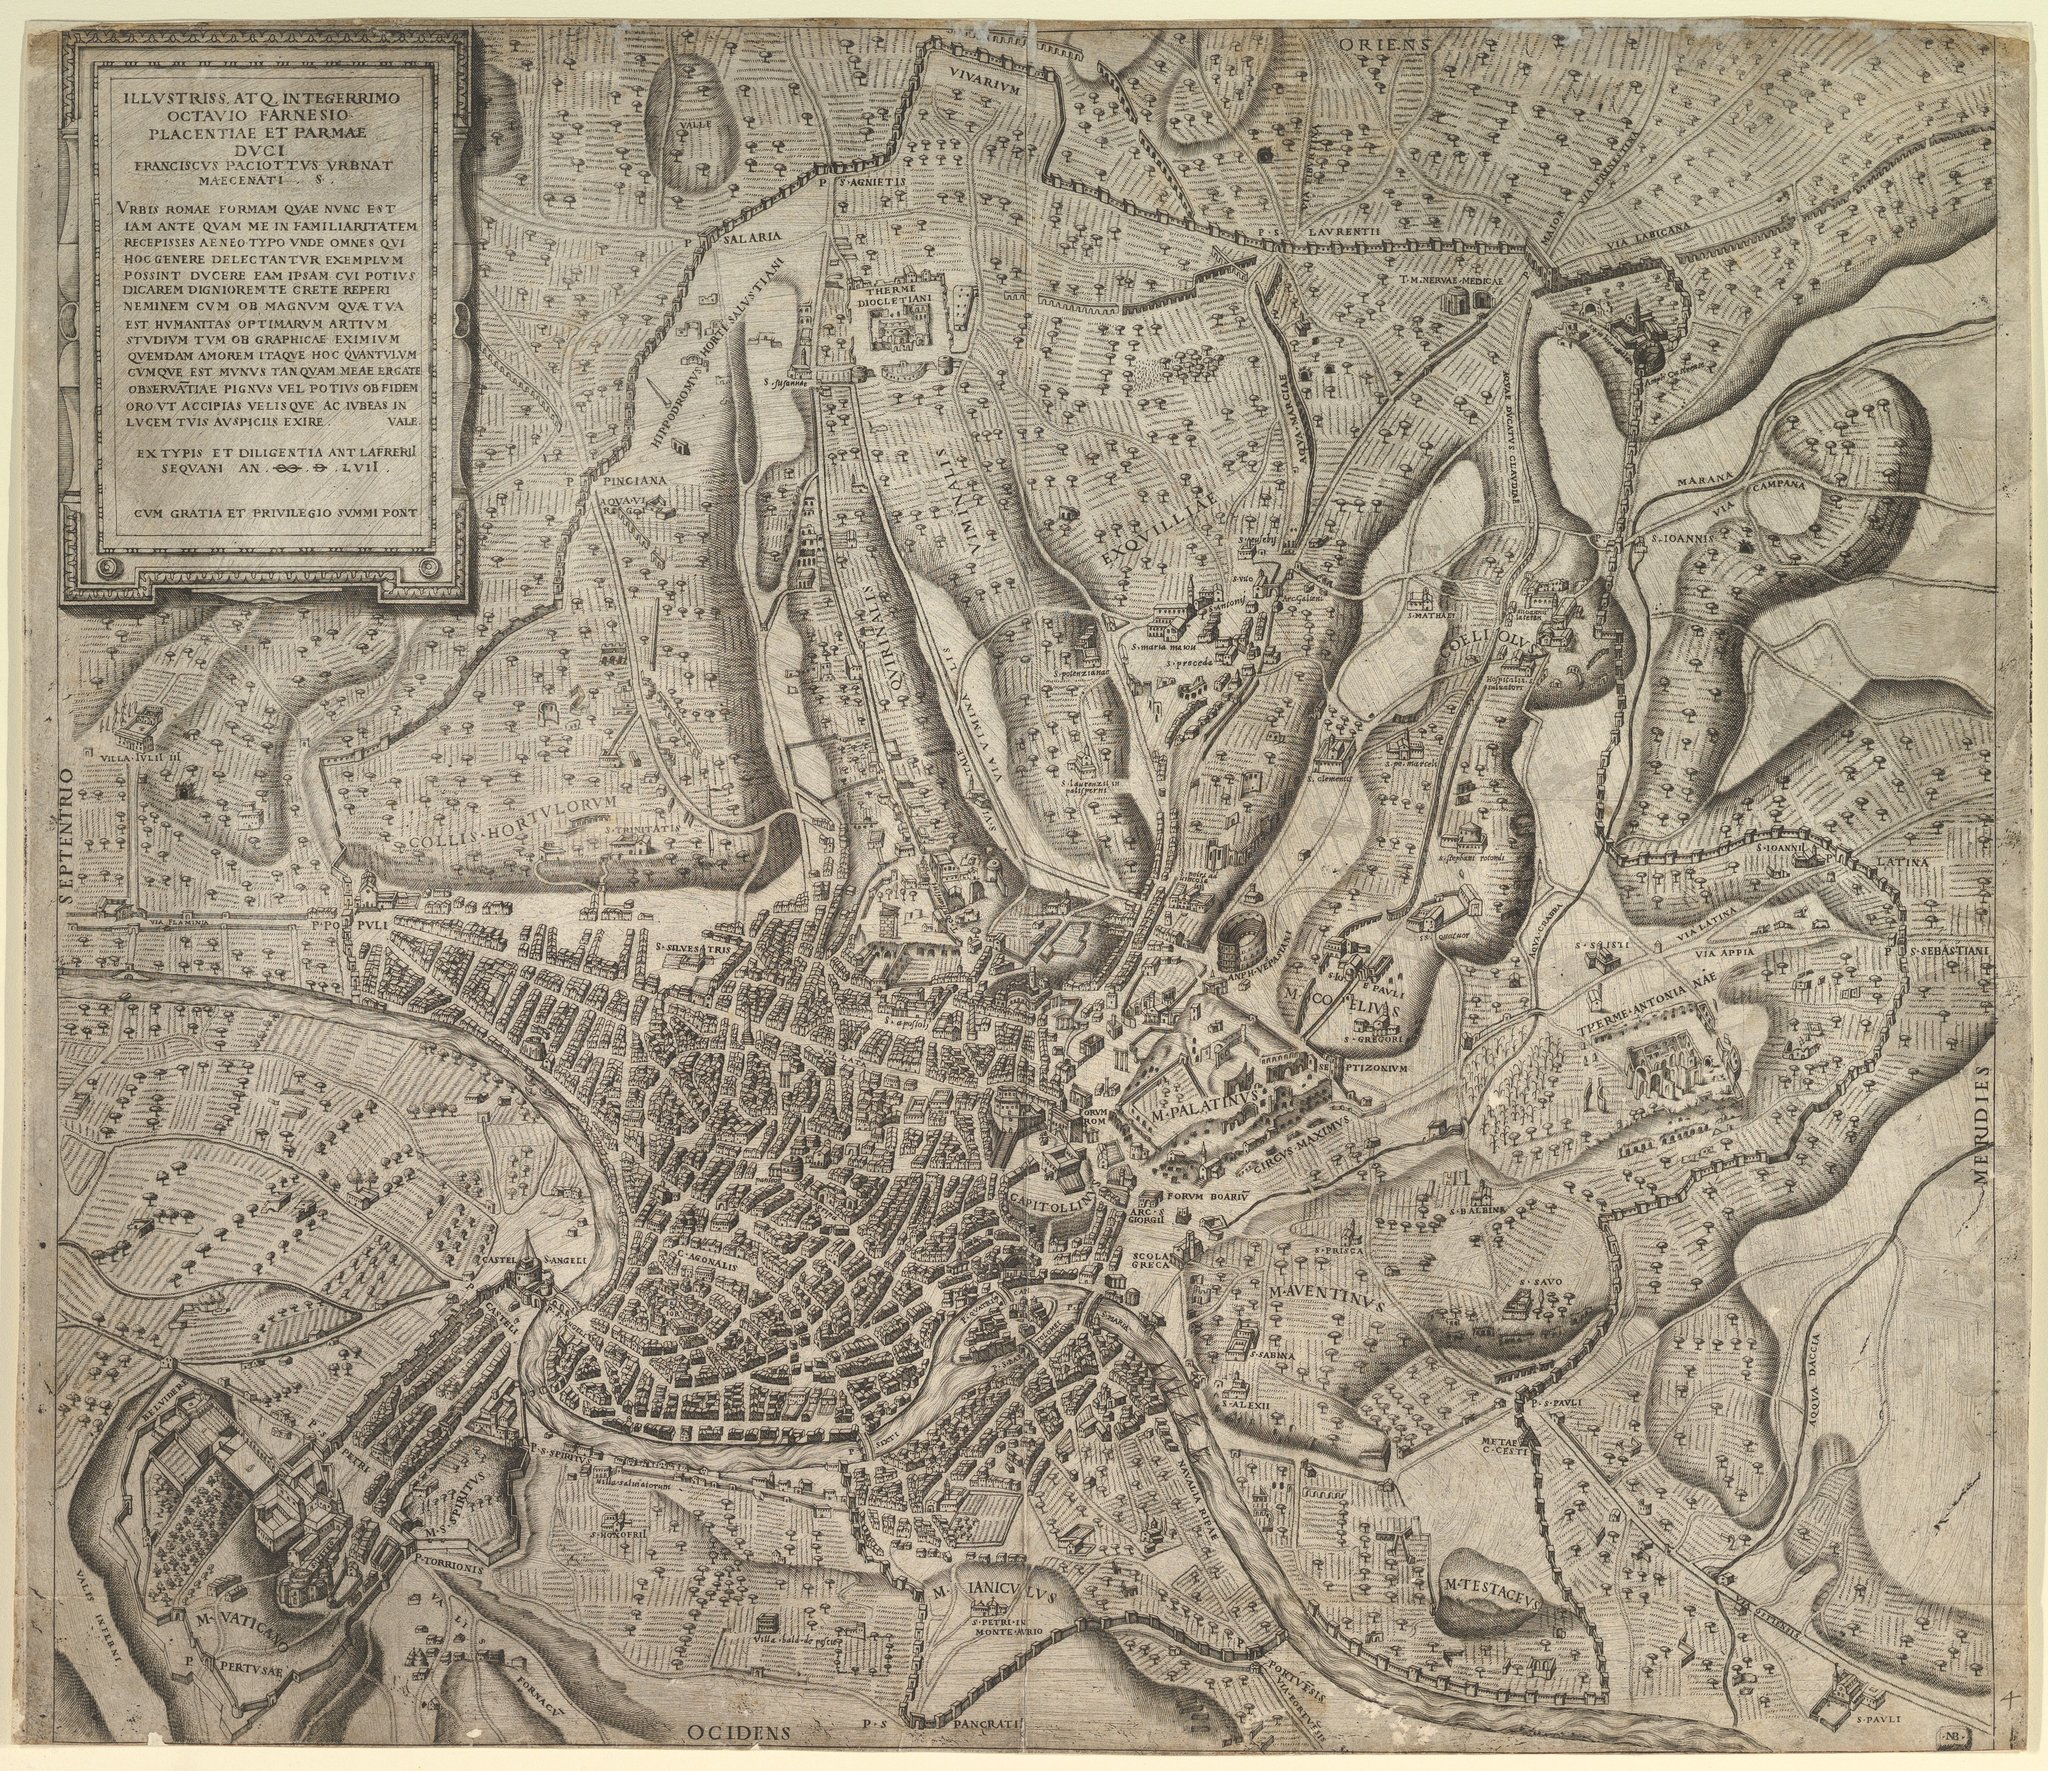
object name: print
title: View of Rome from the West, from "Speculum Romanae Magnificentiae"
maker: nicolas beatrizet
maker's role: artist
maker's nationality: french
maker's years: 1515-1566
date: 1557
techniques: engraving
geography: rome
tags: maps,rome